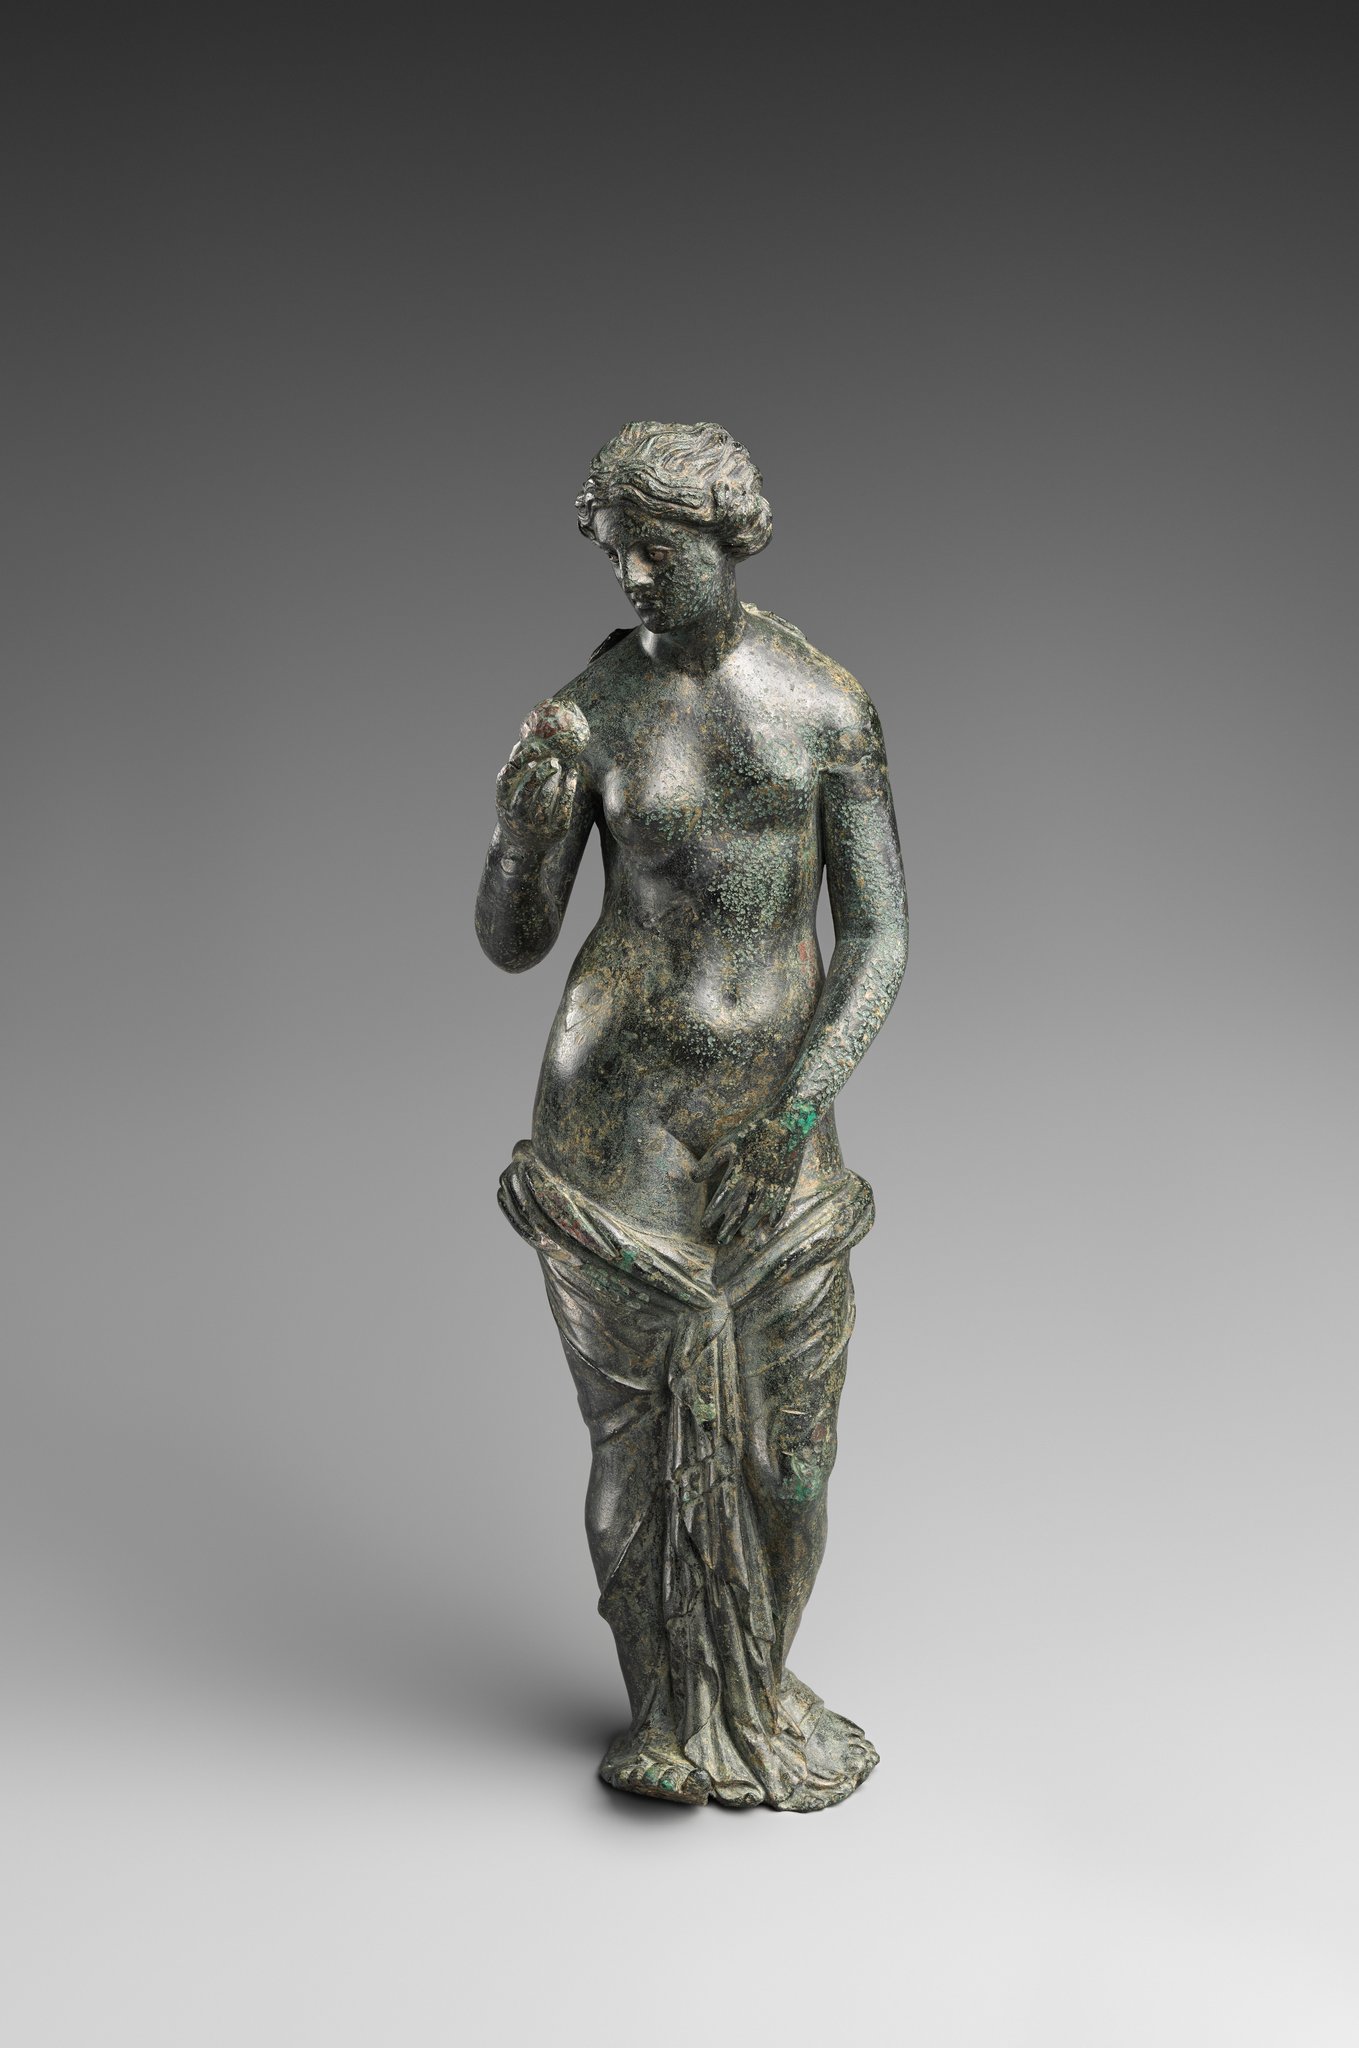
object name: statuette of aphrodite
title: Bronze statuette of Aphrodite with silver eyes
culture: greek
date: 300-1 BCE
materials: bronze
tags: aphrodite